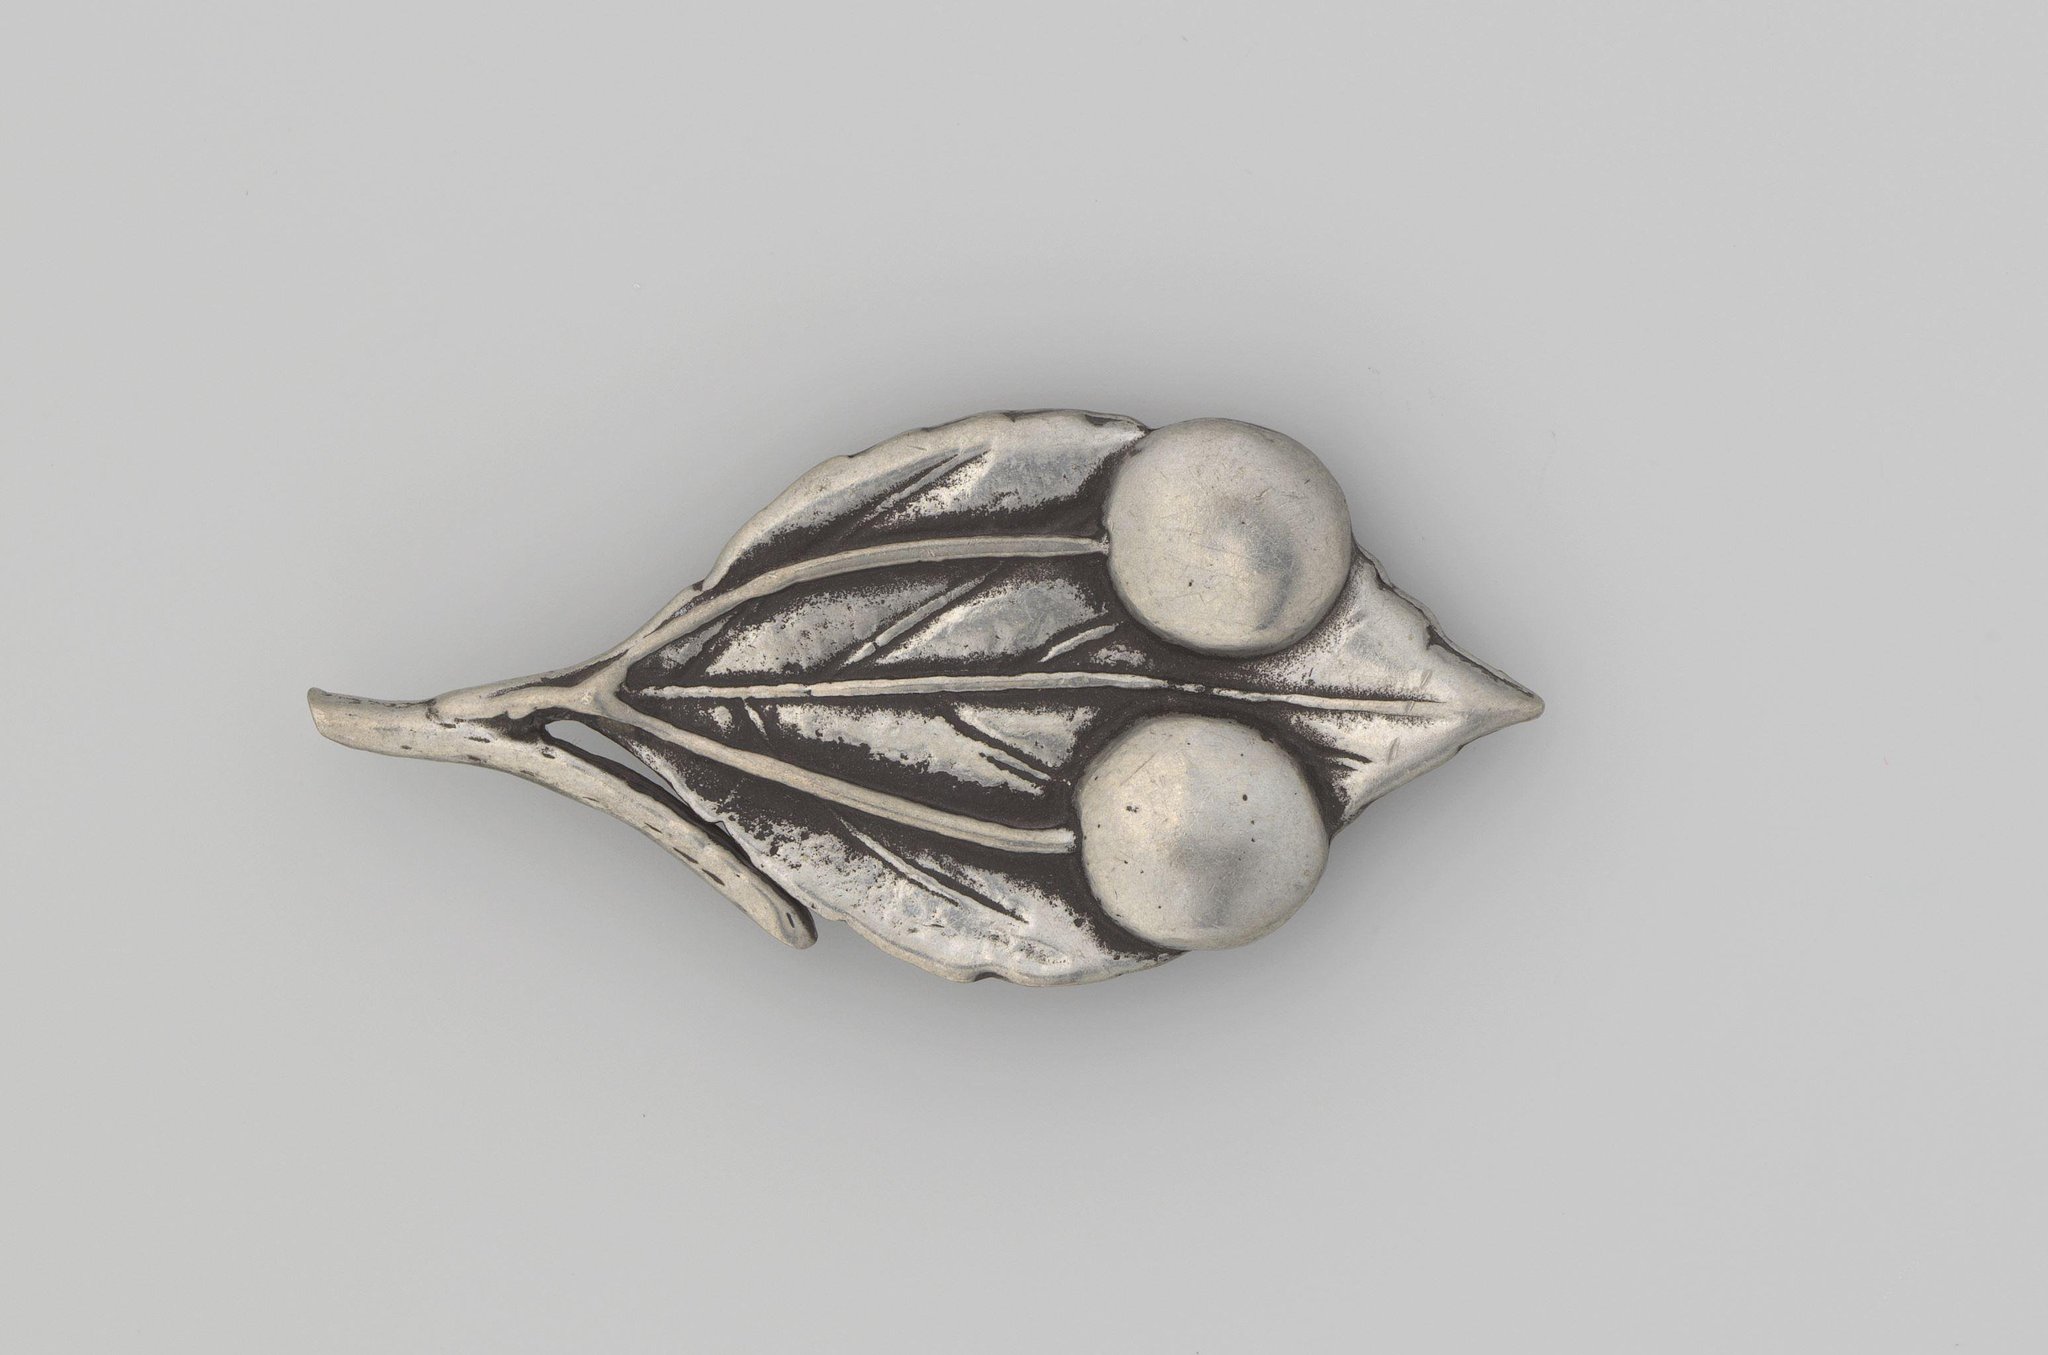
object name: brooch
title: Broche van tin met kersen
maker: Anonymous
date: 1940-1960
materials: tin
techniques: casting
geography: tiel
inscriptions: : ‘Handmade, Tiel, 94% tin’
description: Broche met bladvorm waarop een takje met twee kersen.